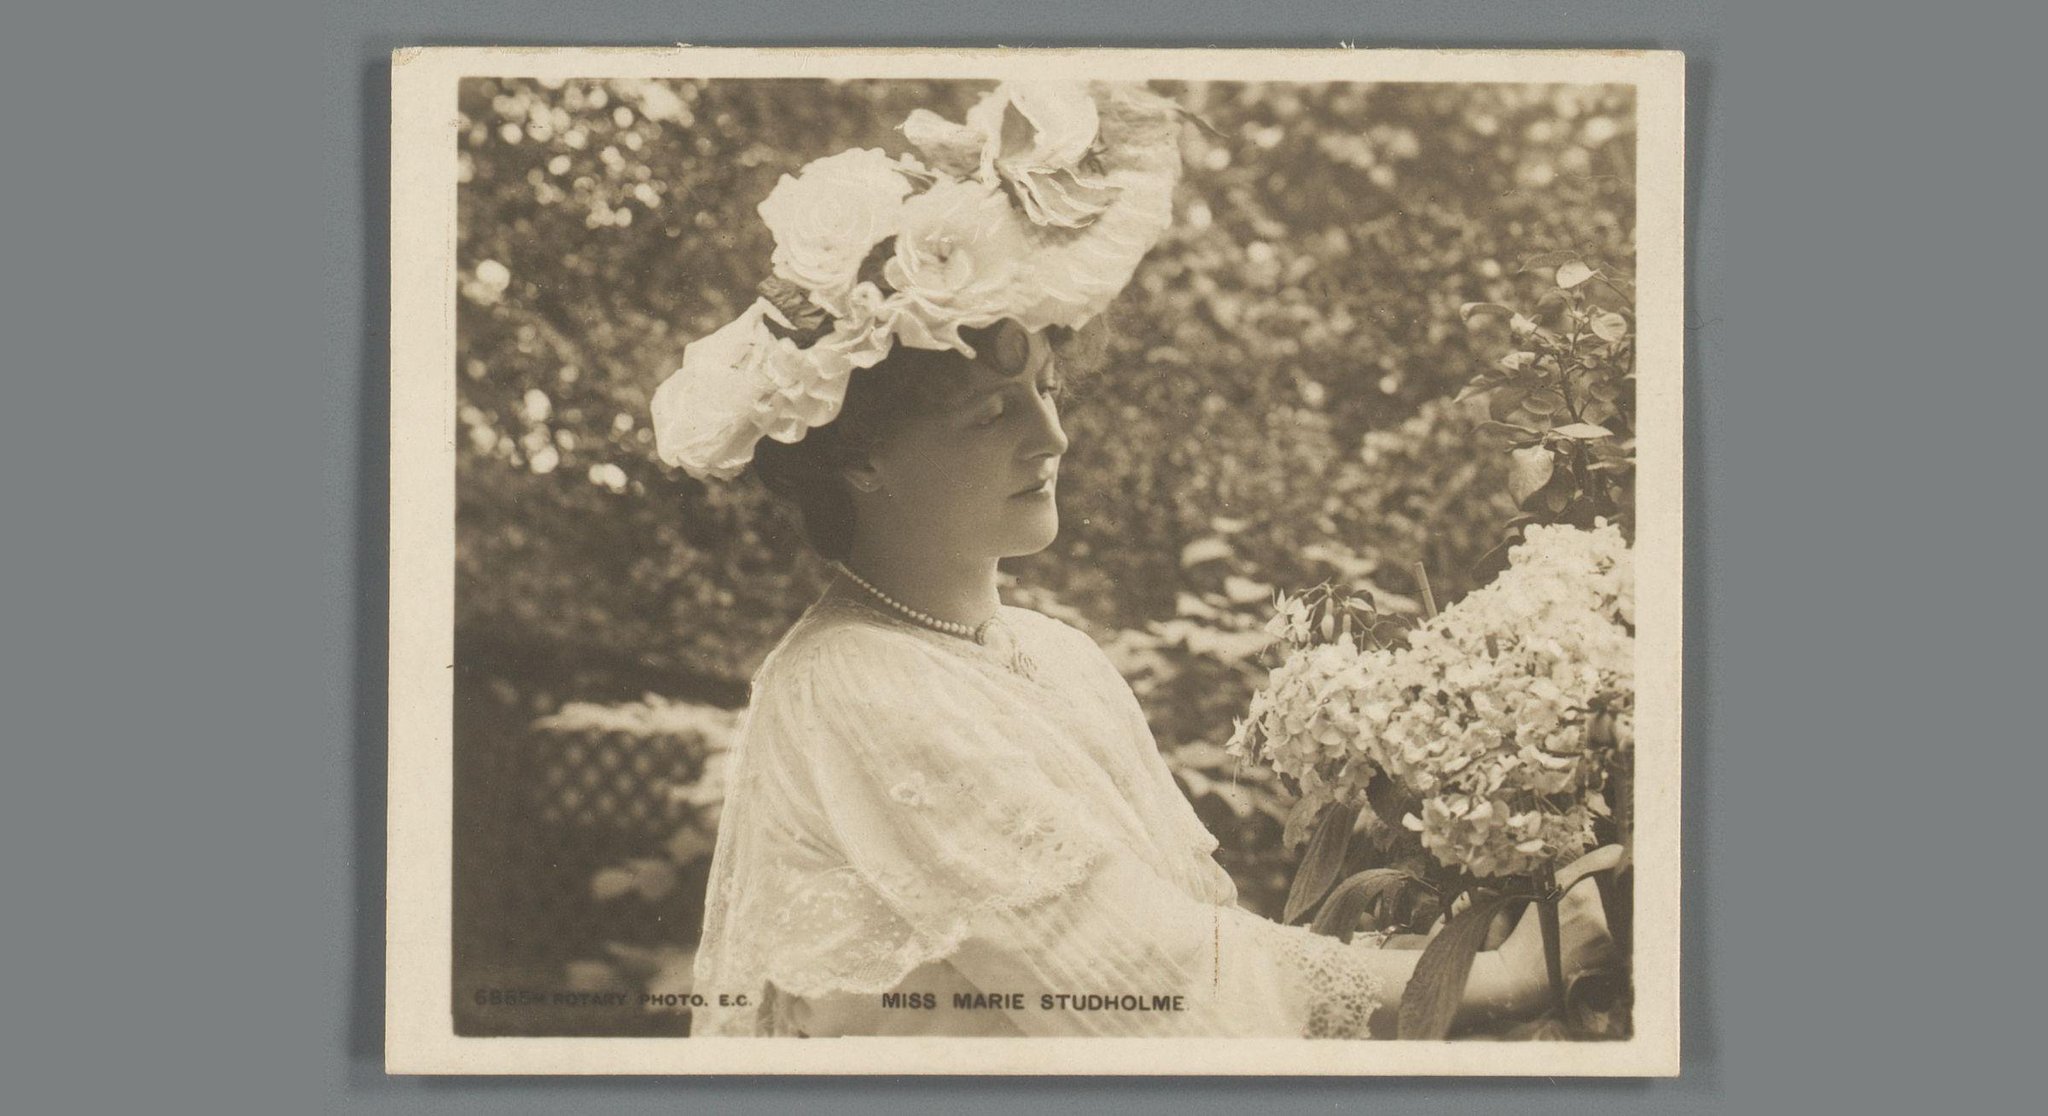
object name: photograph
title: Portret van Marie Studholme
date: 1900-1916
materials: paper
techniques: gelatin silver print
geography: london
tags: historical persons - bb - woman, portrait of actor, actress, london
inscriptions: inscription: ‘With dearest/ fondest/ love from/ A.M.F.’, inscription: ‘6865m Rotary Photo E.C. Miss Marie Studholme’, inscription: ‘Midget Post Card (...) Foreign.’